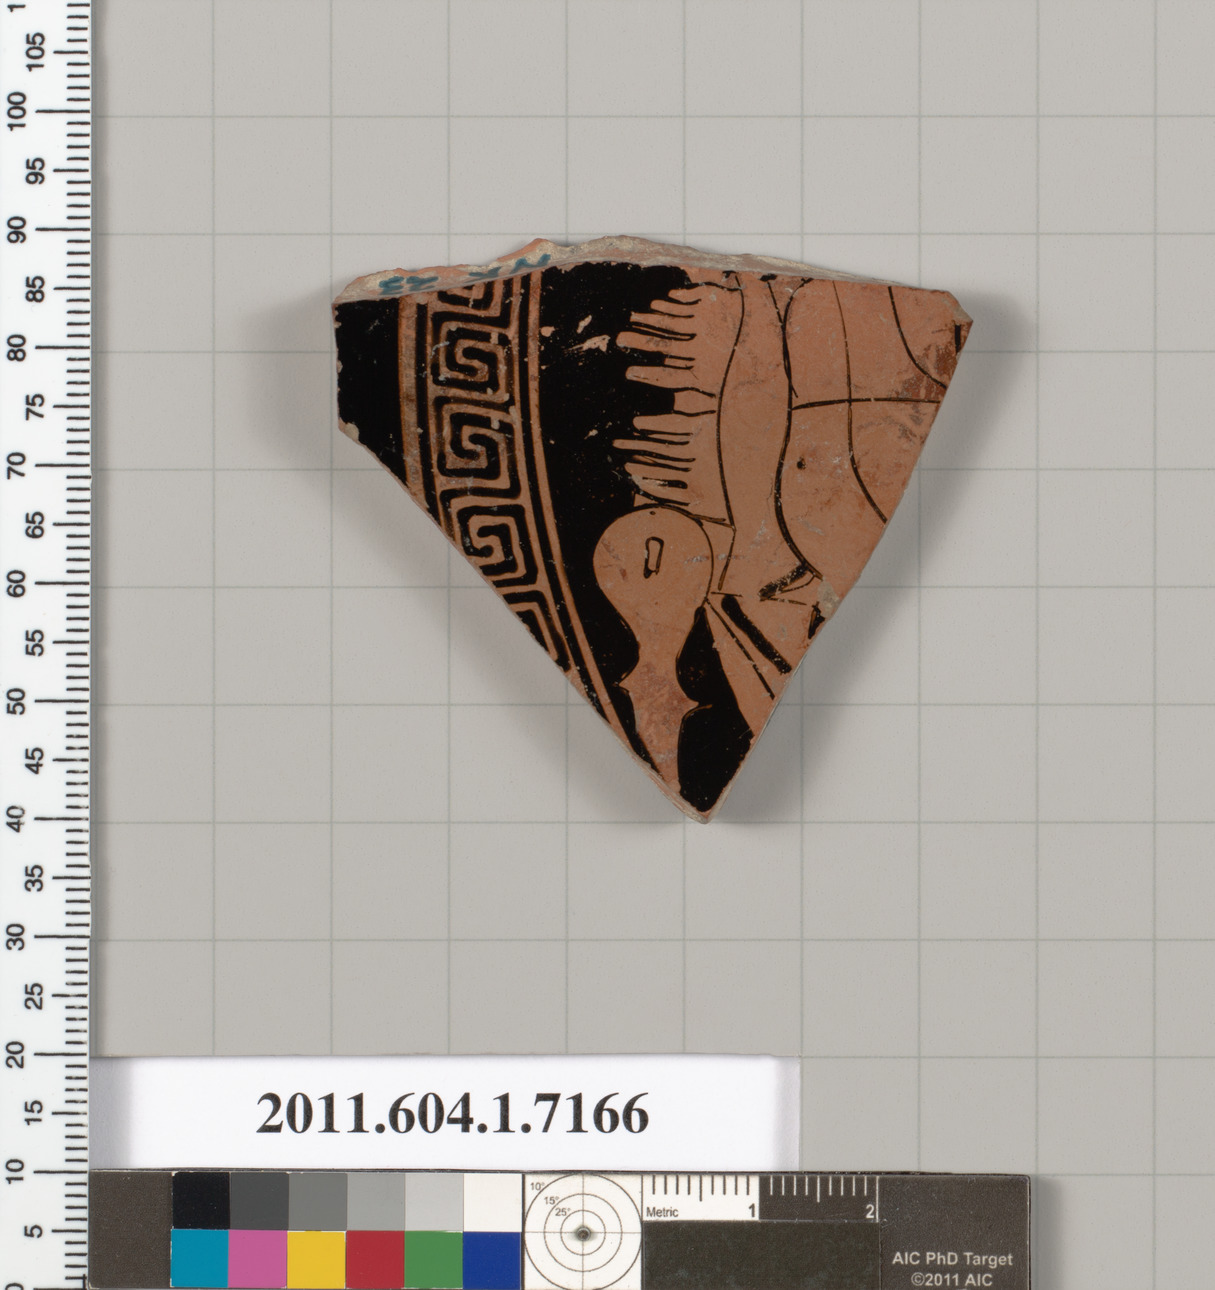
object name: kylix fragment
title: Terracotta fragment of a kylix (drinking cup)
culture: greek, attic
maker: makron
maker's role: artist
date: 500-480 BCE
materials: terracotta